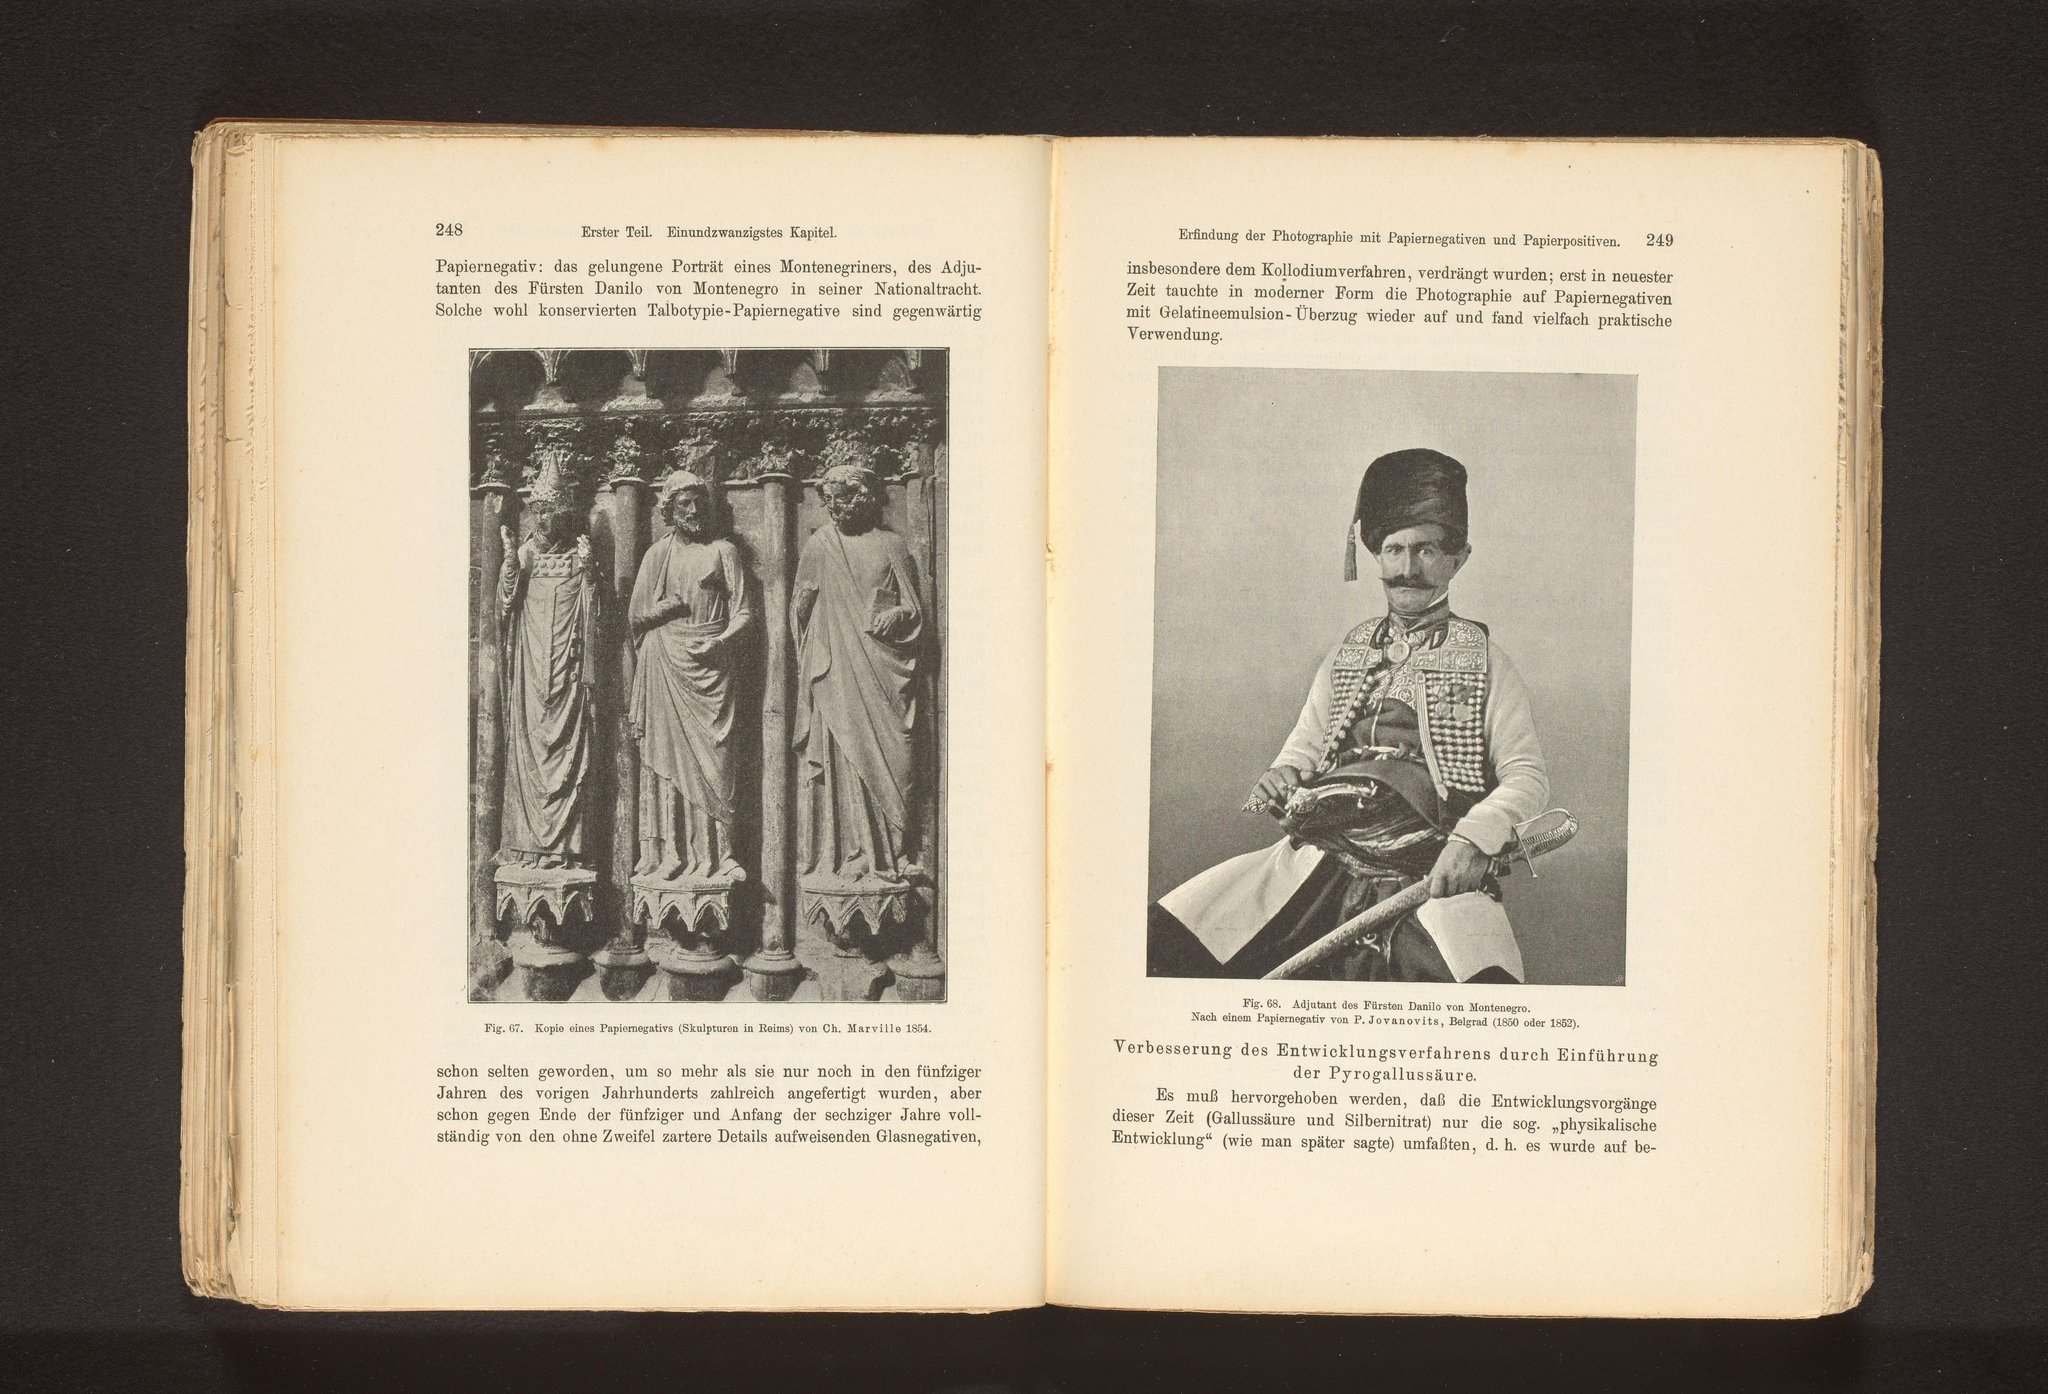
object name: photomechanical print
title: Kopie eines Papiernegativ (Skulpturen in Reims) von Ch. Marville 1854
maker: Anonymous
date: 1900-1905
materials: paper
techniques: autotype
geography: reims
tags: church (exterior), sculpture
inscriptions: number: ‘Fig. 67.’